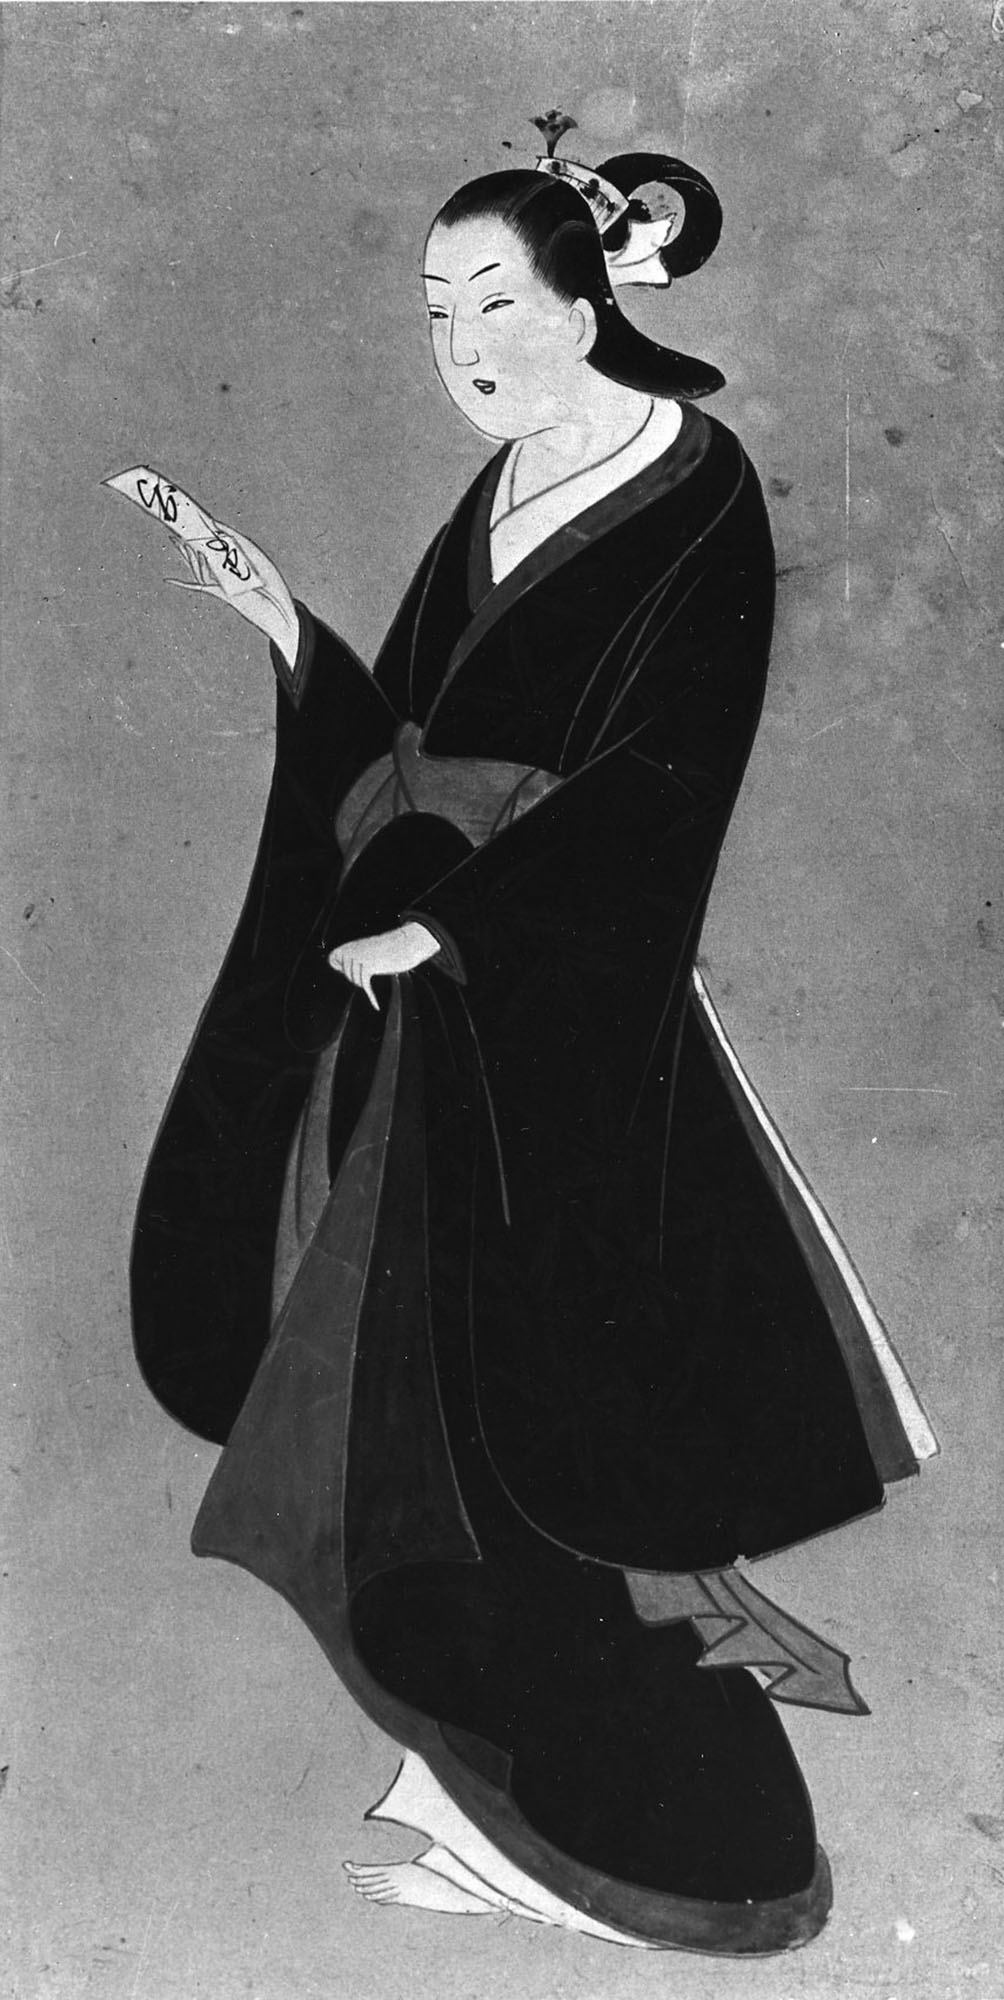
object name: painting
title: Beauty with Letter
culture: japanese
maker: kaigetsudō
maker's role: artist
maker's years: 1650-1800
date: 1801-1900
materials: ink, paper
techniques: painting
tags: women